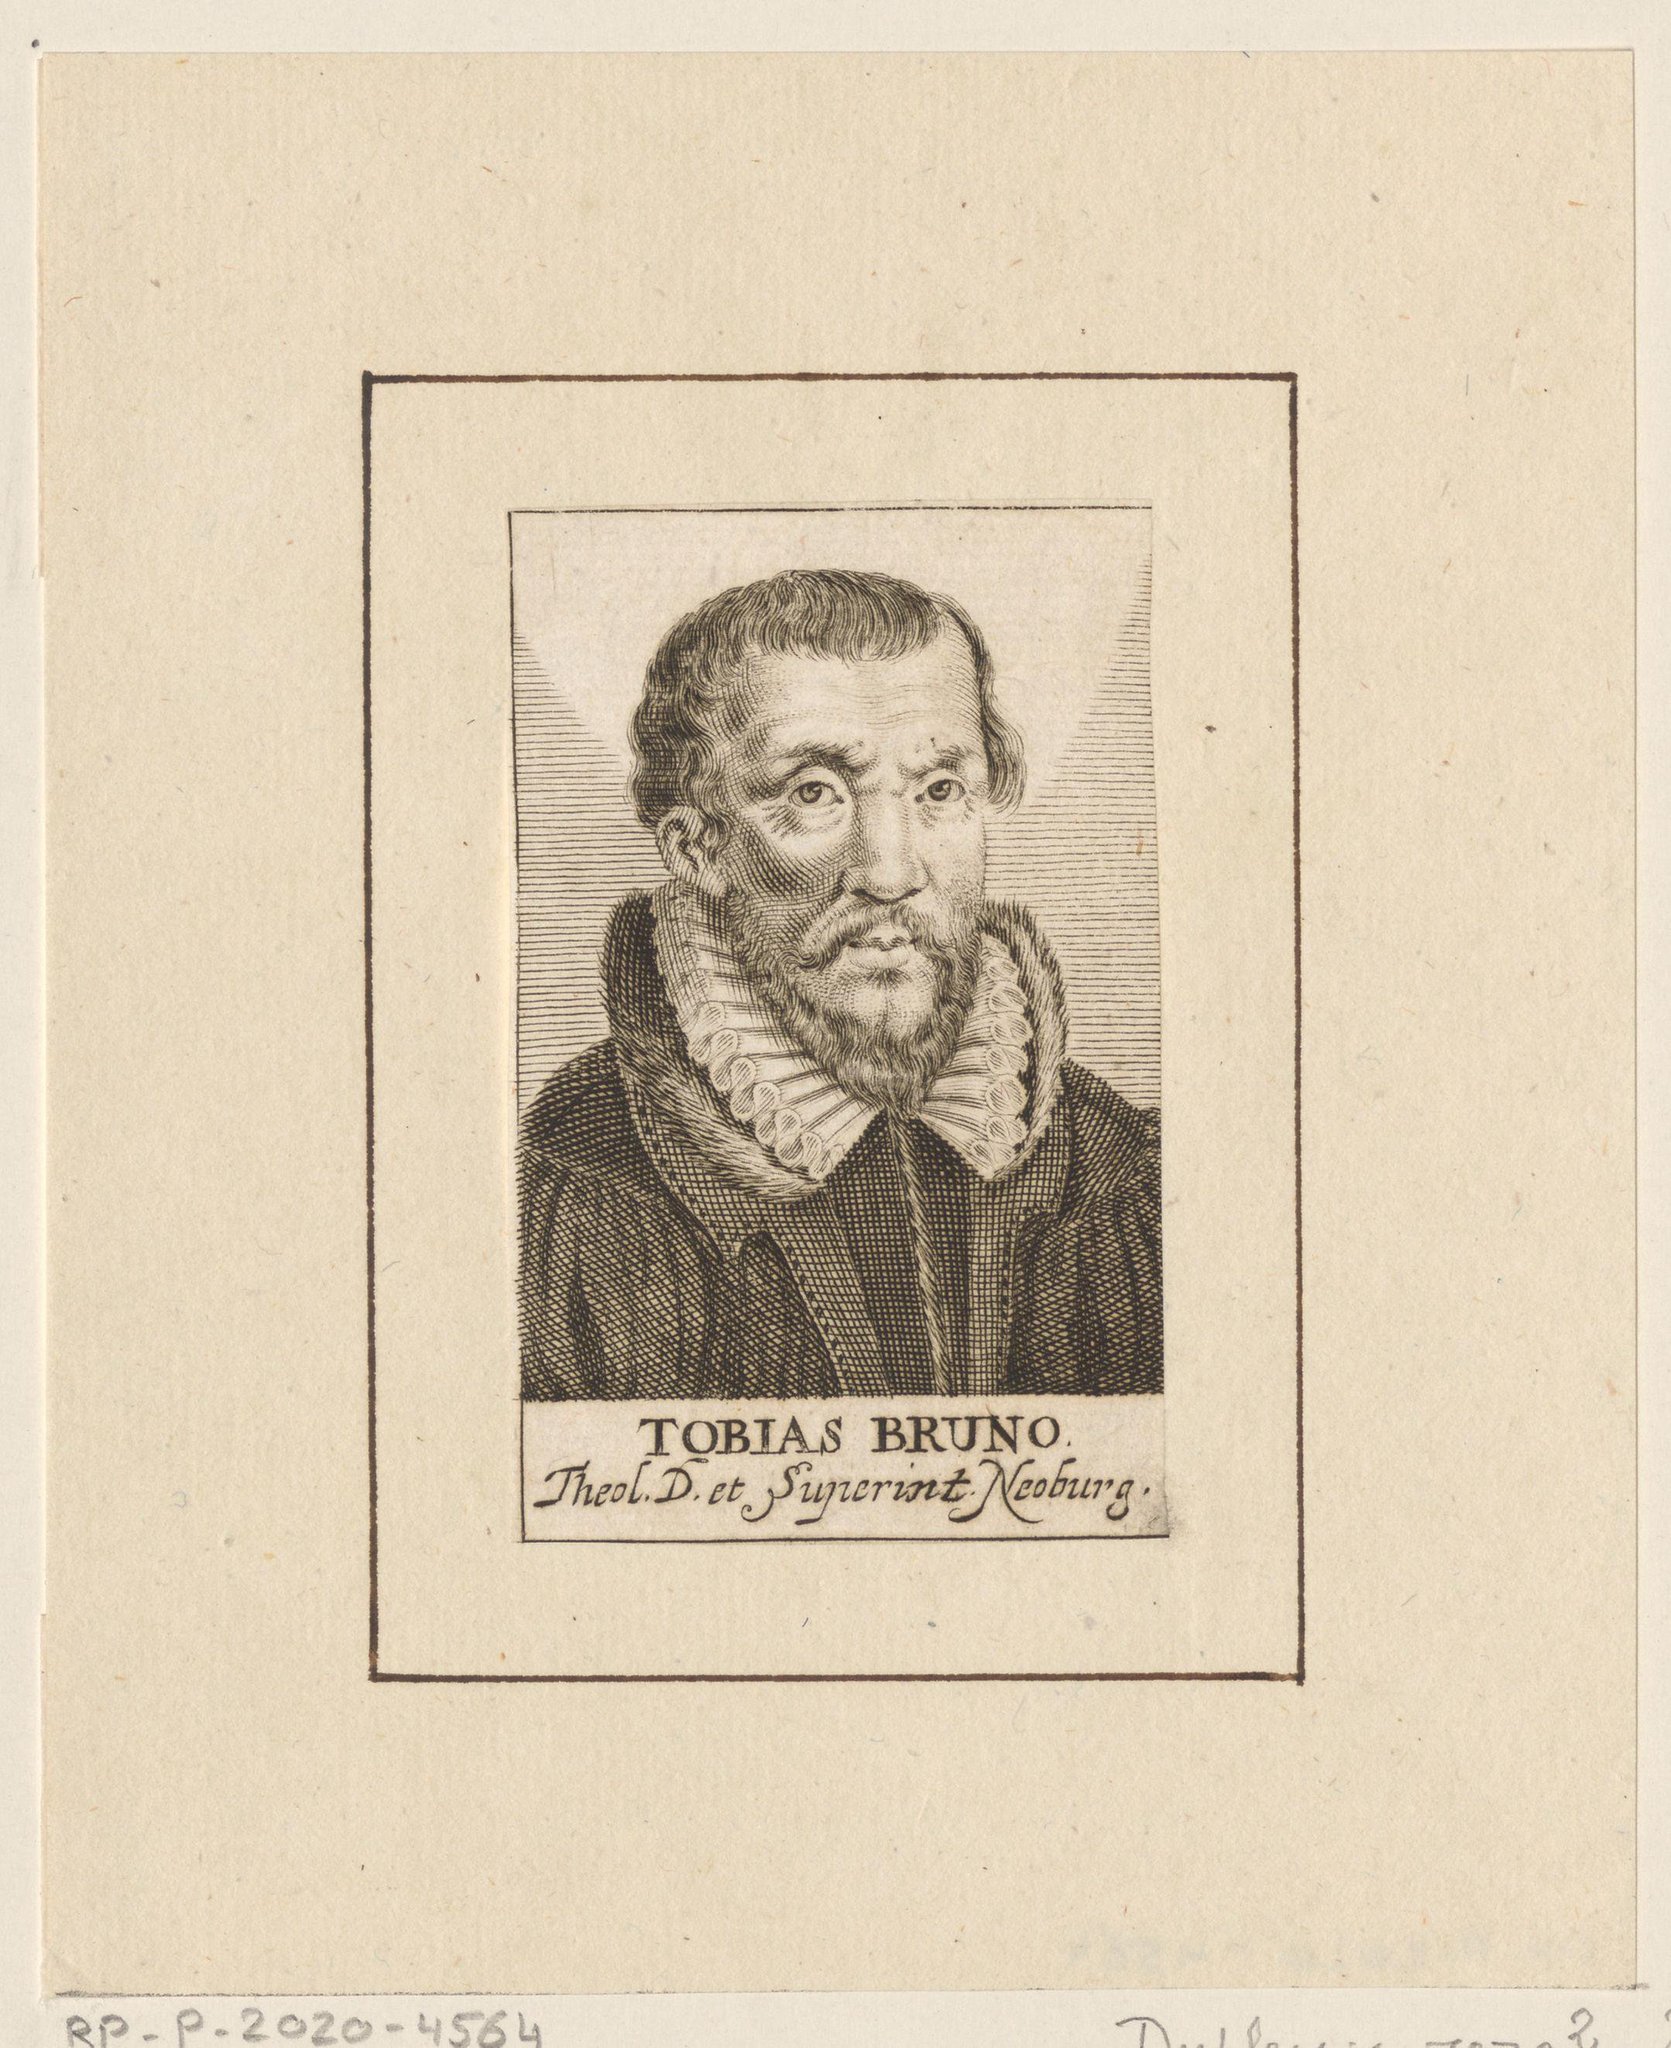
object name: book illustration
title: Portret van Tobias Bruno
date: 1688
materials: paper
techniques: engraving, etching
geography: nuremberg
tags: theologian, historical persons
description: Prent uit: Freher, Paul. Theatrum virorum eruditione clarorum. Neurenberg: Johann Hoffmann, 1688.